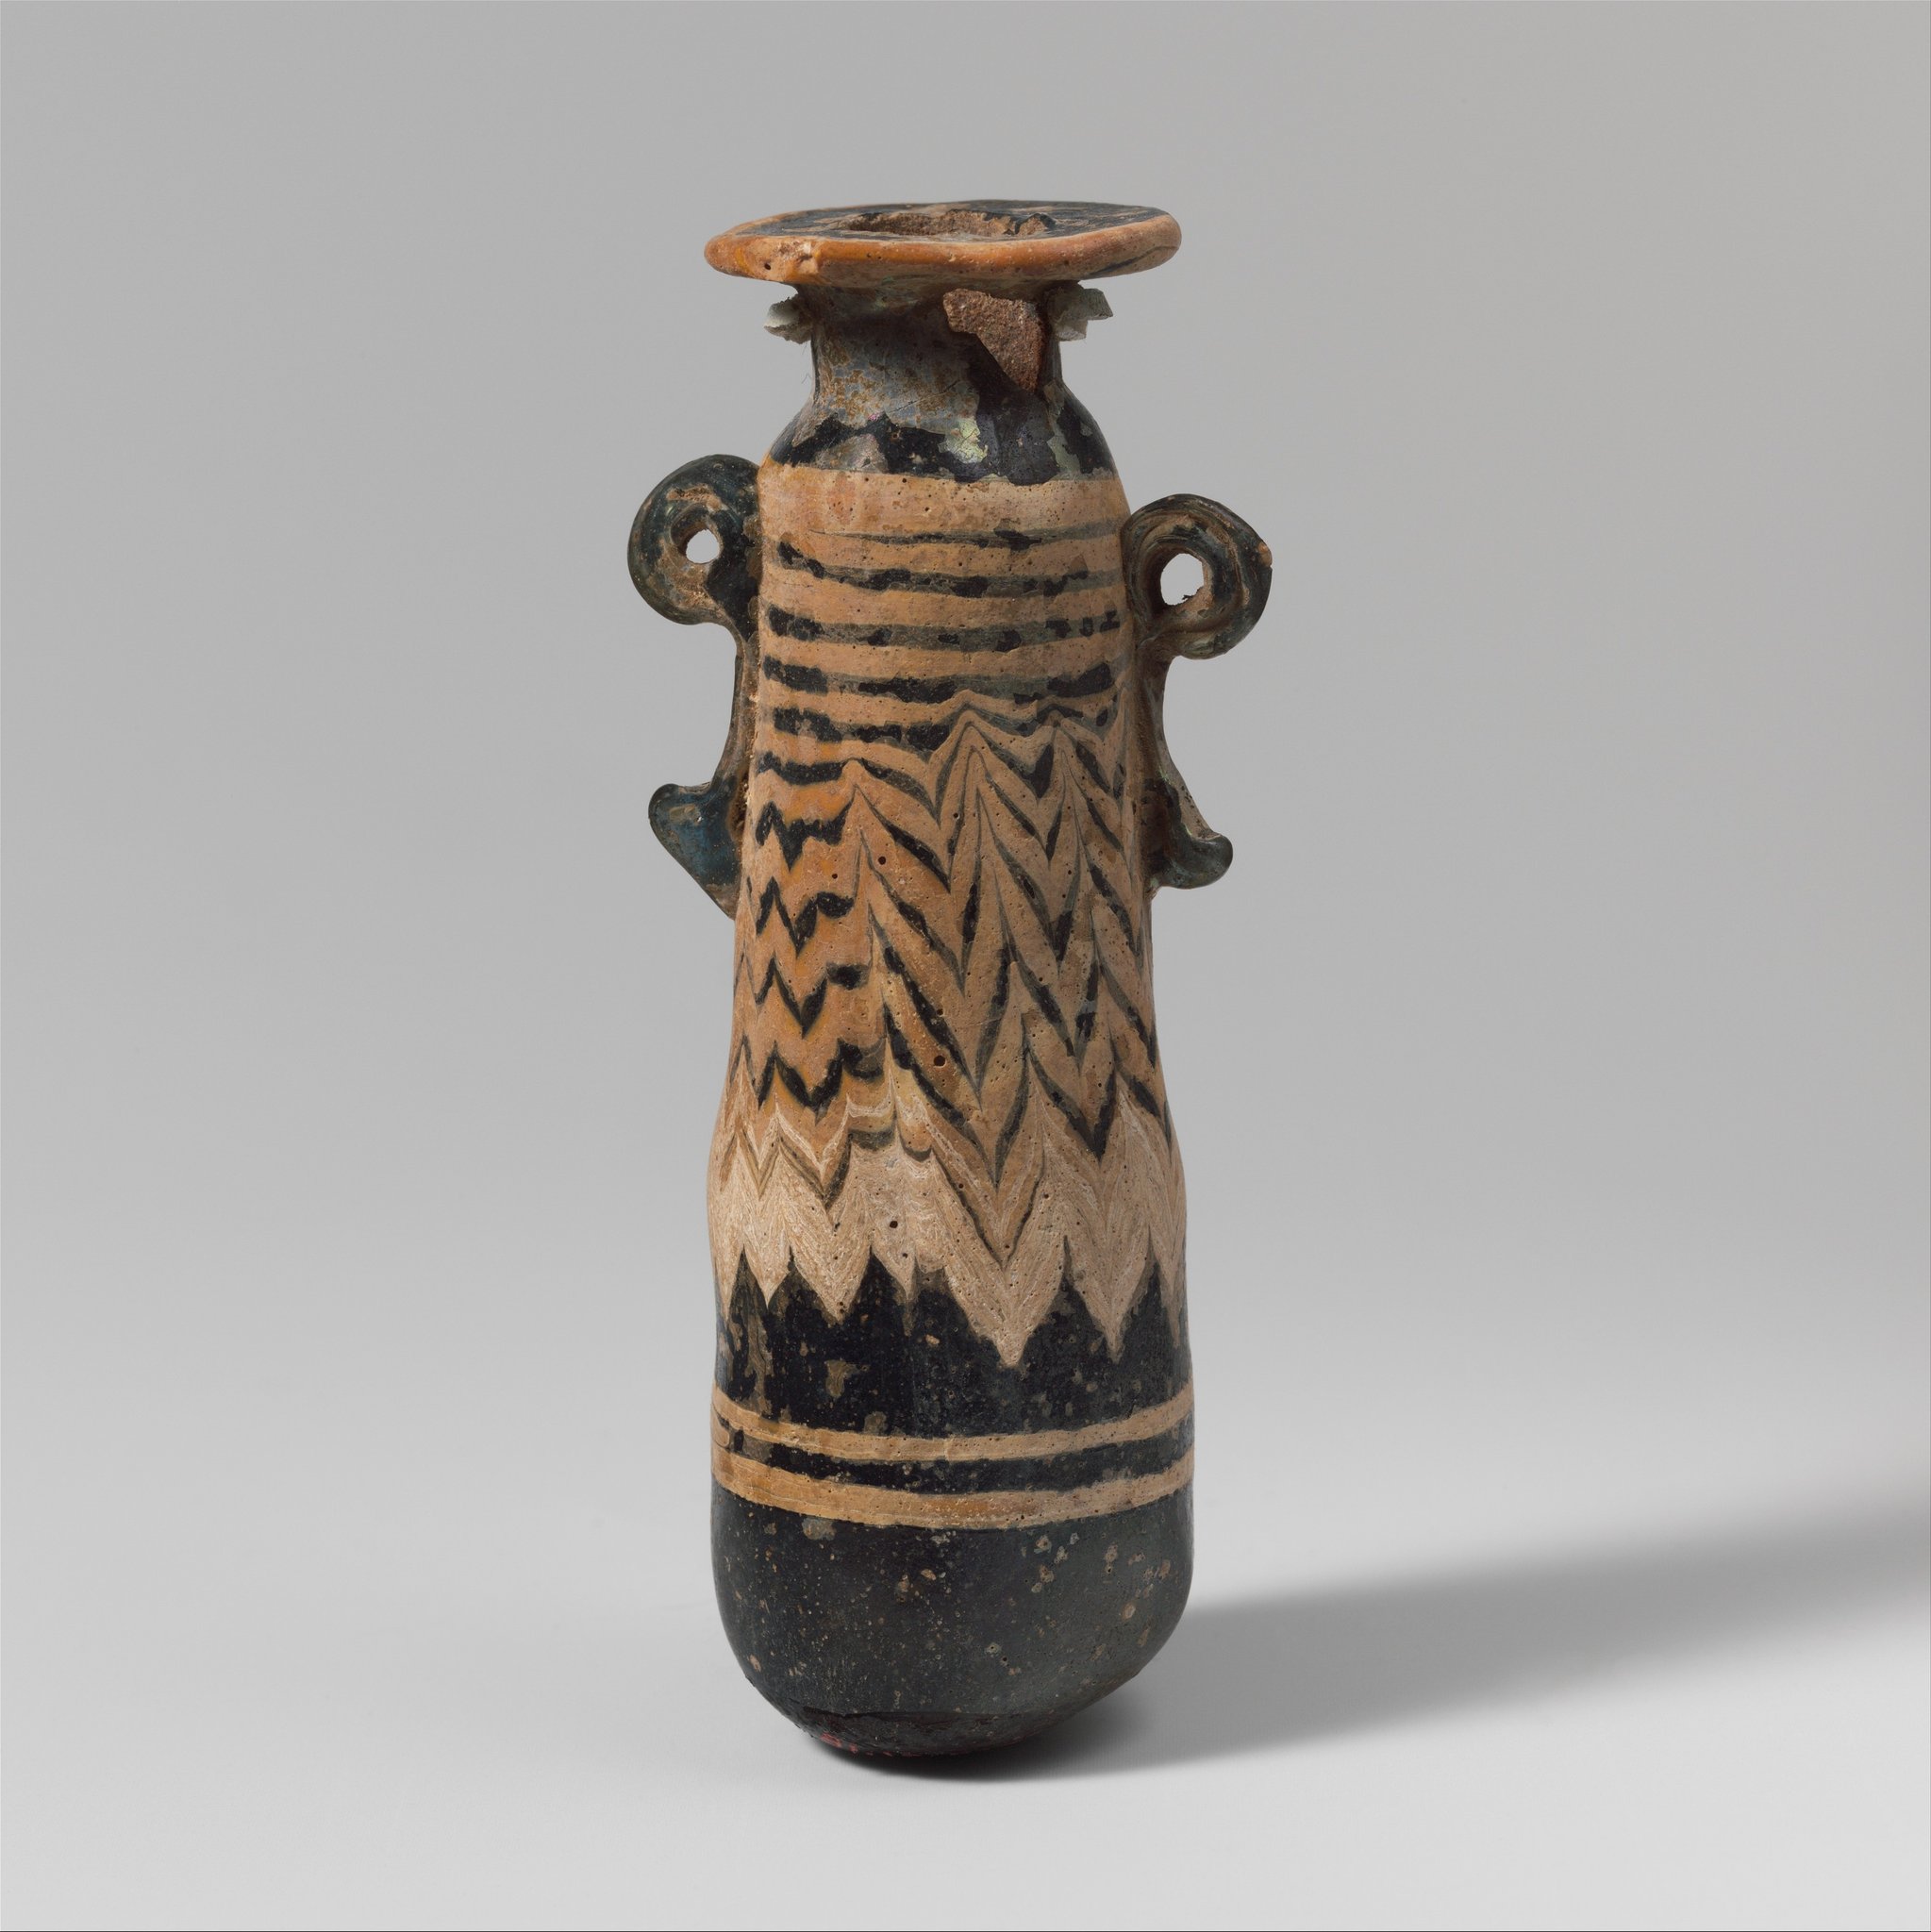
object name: alabastron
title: Glass alabastron (perfume bottle)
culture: greek, eastern mediterranean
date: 534-401 BCE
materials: glass